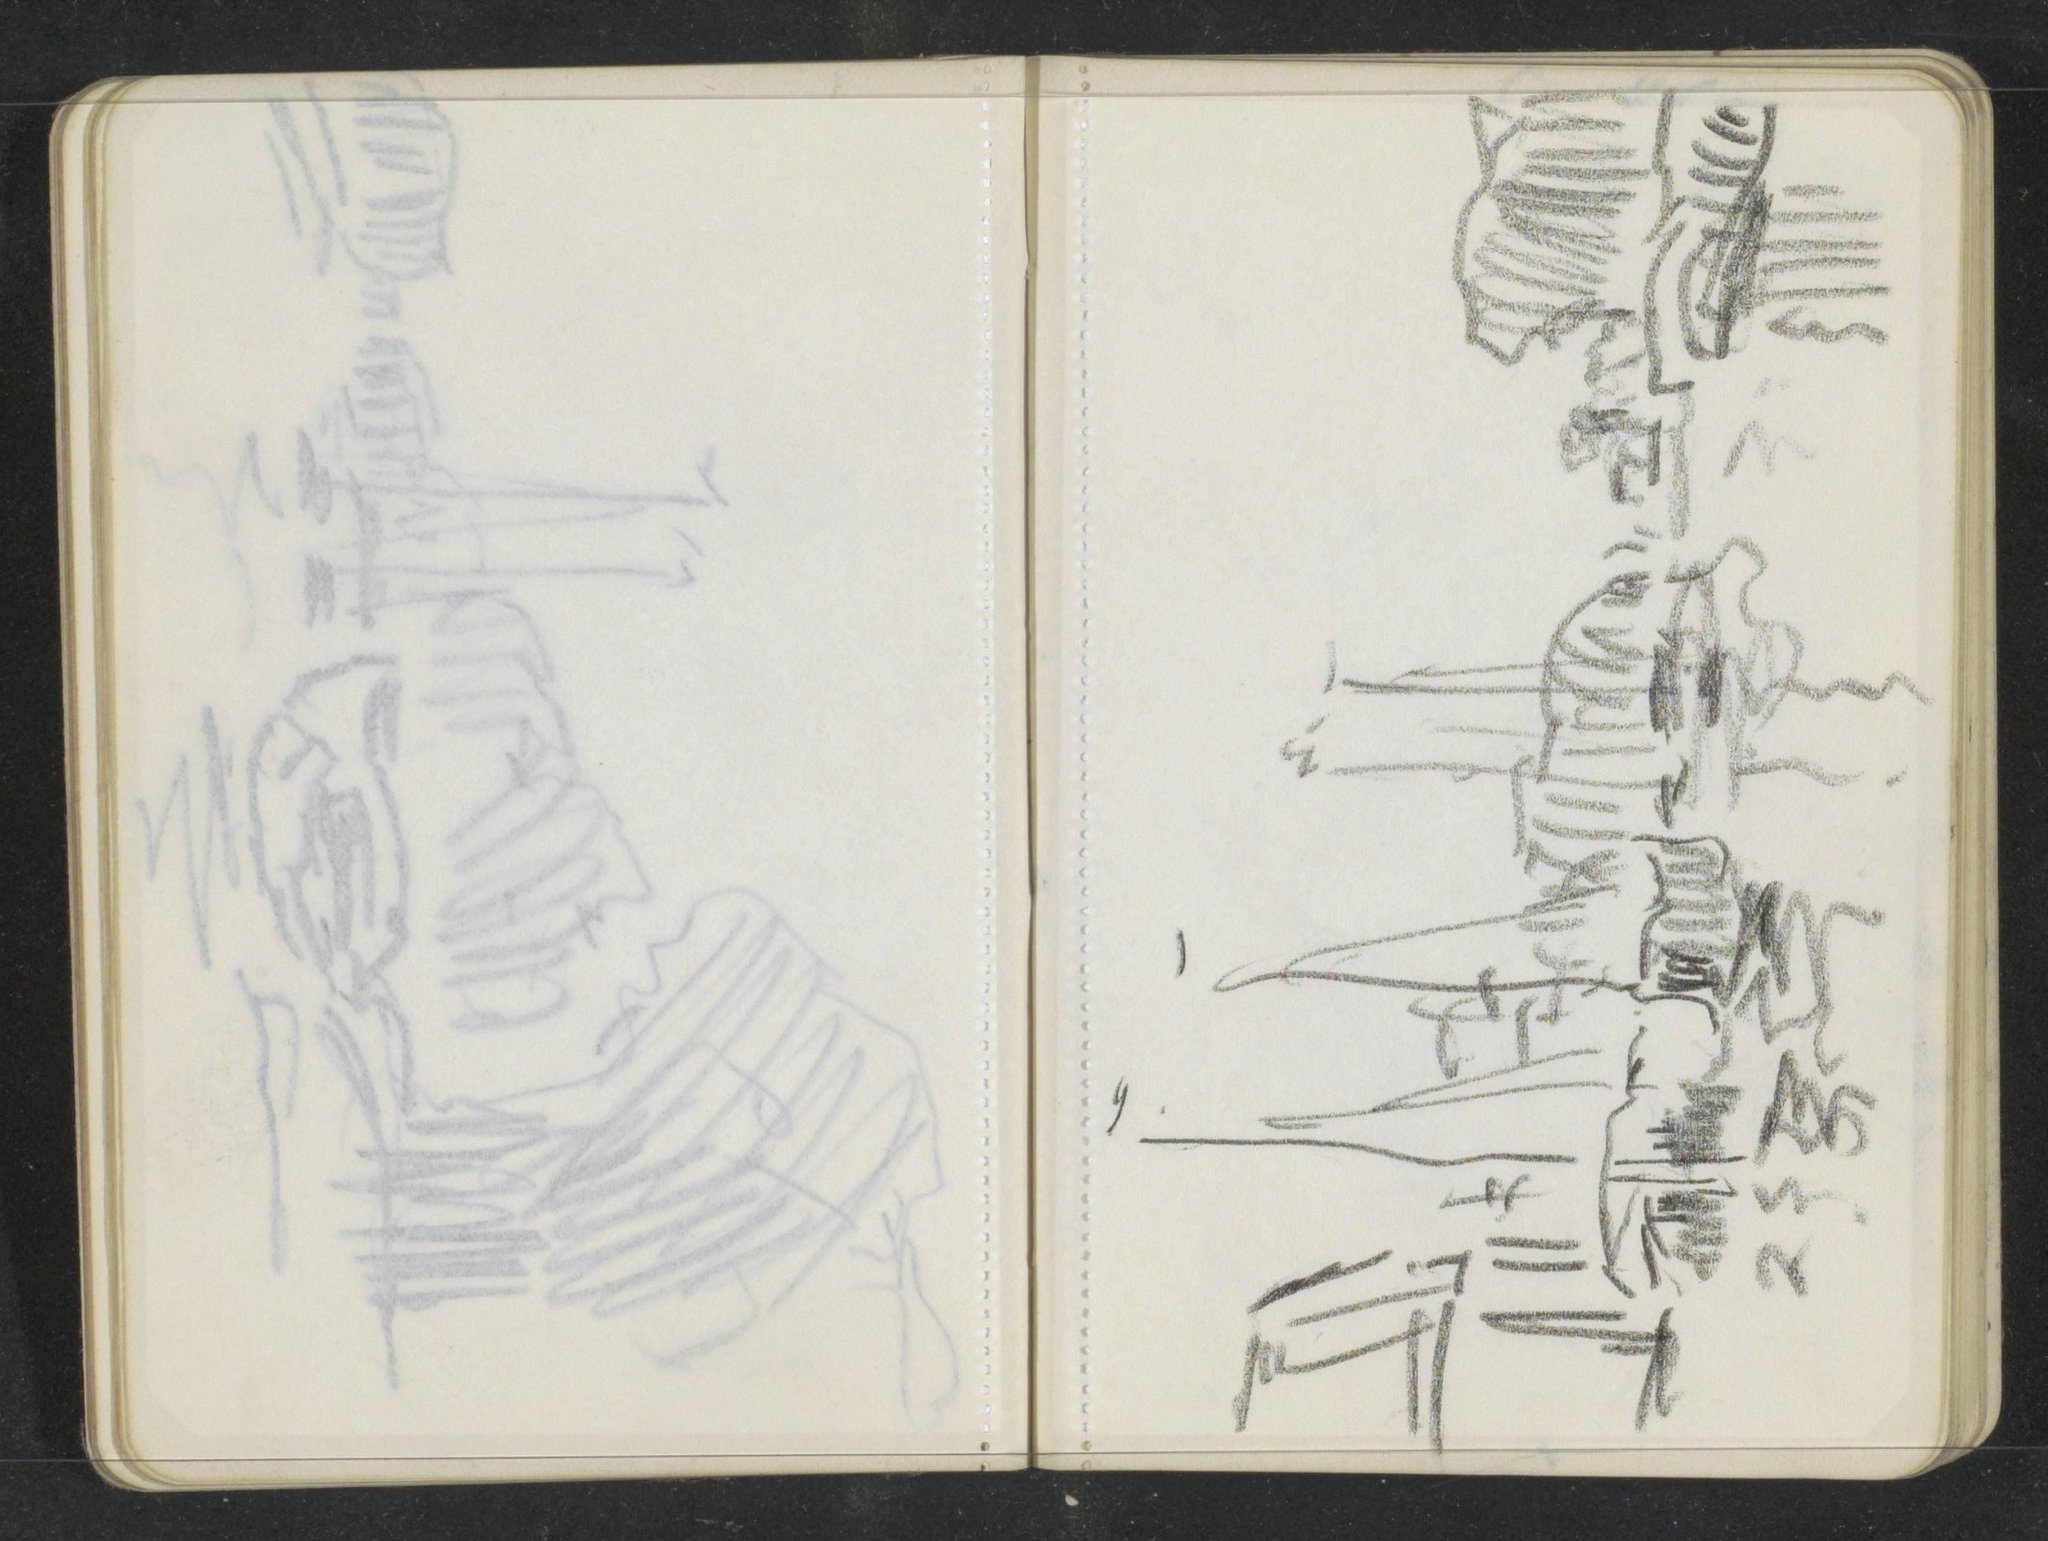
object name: sketchbook leaf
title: Zeilboten op een rivier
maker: alexander shilling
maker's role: draughtsman, print maker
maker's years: 1859-1937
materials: chalk, paper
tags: sailing-ship, sailing-boat, landscapes with waters, waterscapes, seascapes (in the temperate zone)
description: Langs de waterkant staan huizen. Blad 29 recto uit een schetsboek met 91 bladen.